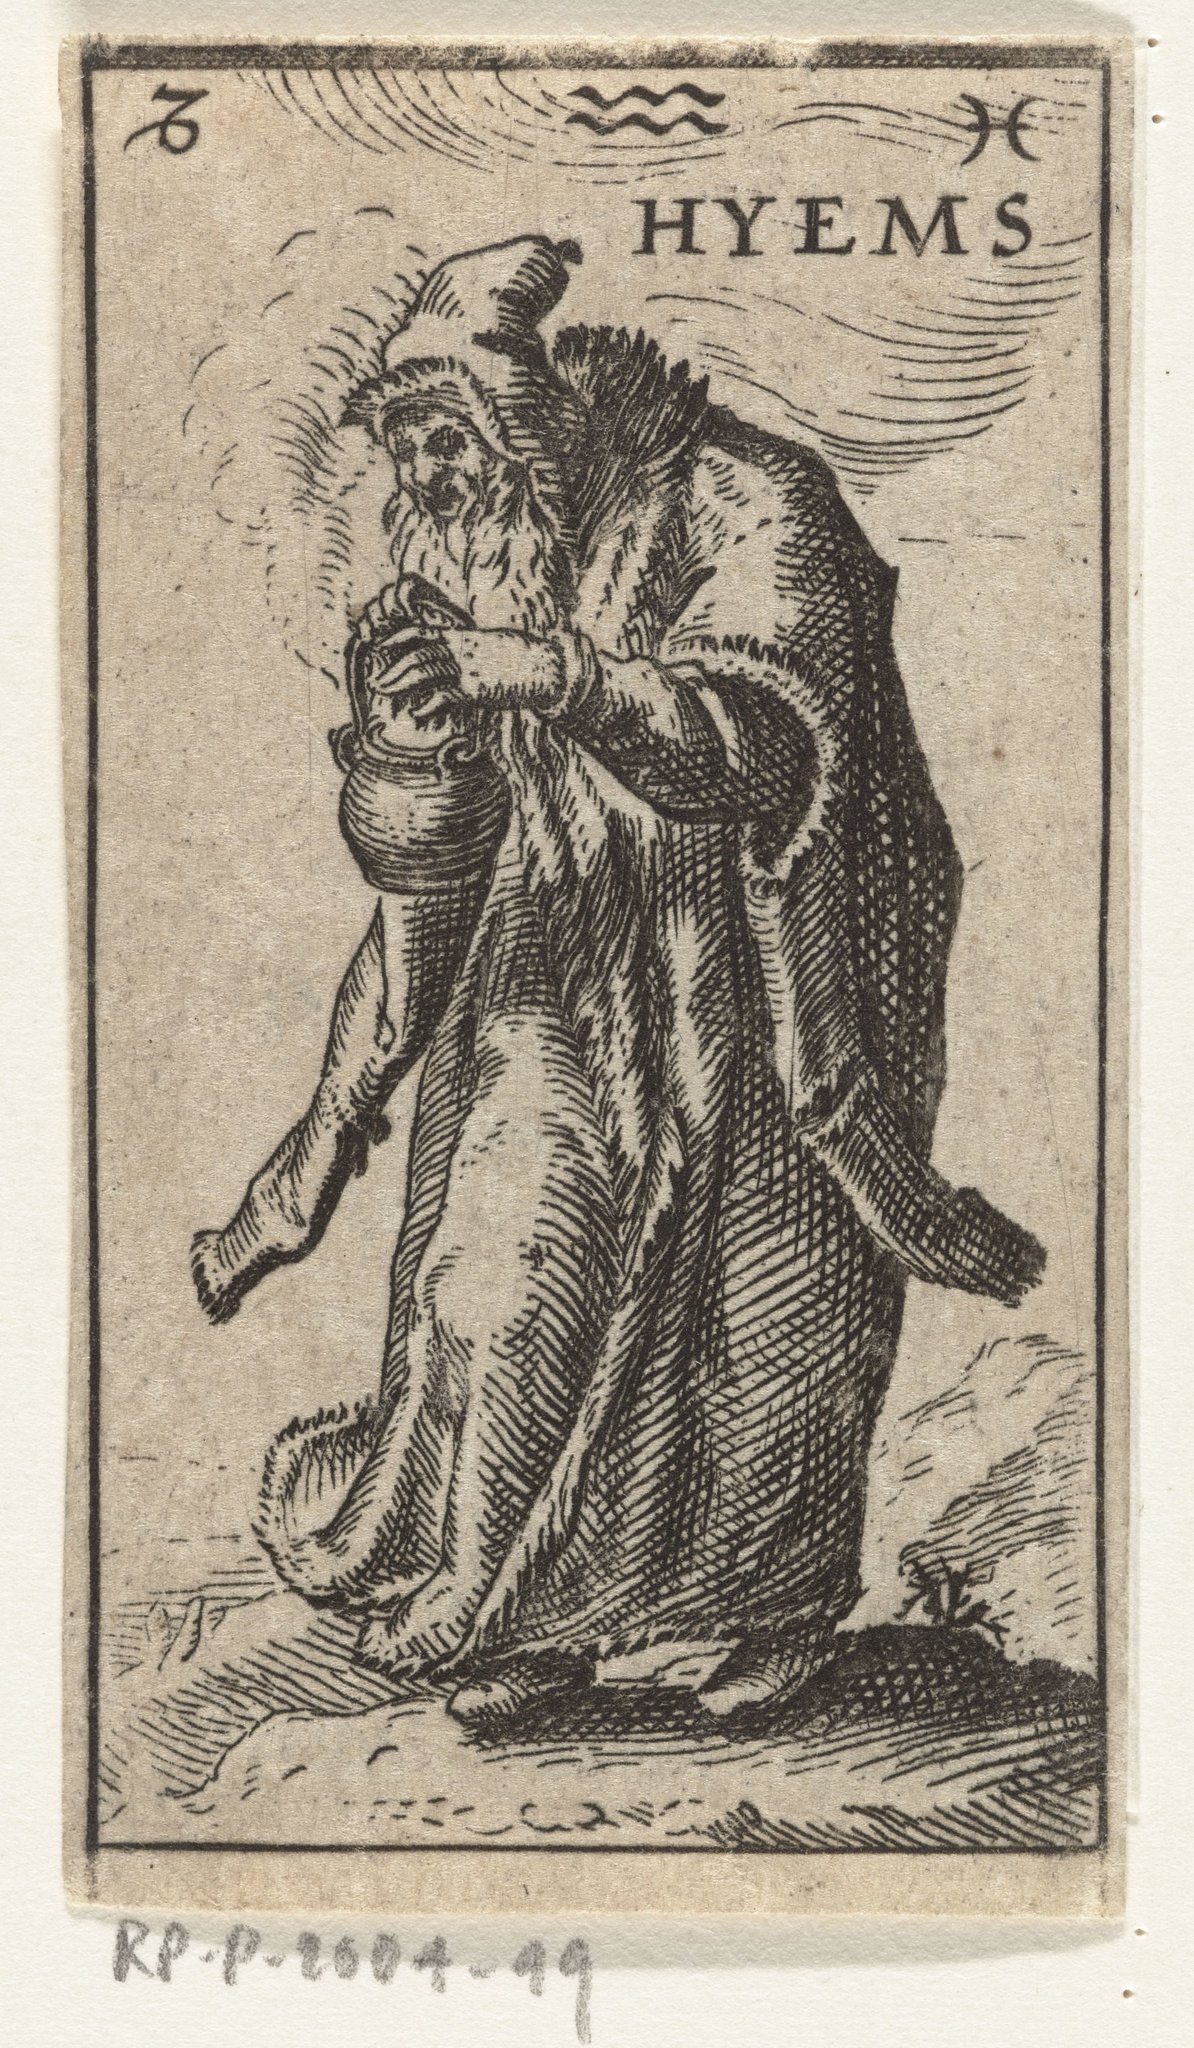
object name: print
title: Hyems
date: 1606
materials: paper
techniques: engraving, etching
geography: netherlands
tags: winter, 'hyems'; 'inverno' (ripa), zodiacal signs of the winter season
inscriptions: collector's mark: Lugt 2228, collector's mark: Lugt 2760, title: ‘HYEMS’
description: De personificatie van de winter, een oude gebogen man gekleed in lange jas afgezet met bont, hoge muts met oorkleppen op zijn hoofd, een vuurpot in de handen. Bovenaan de drie sterrenbeelden Steenbok, Waterman en Vissen.